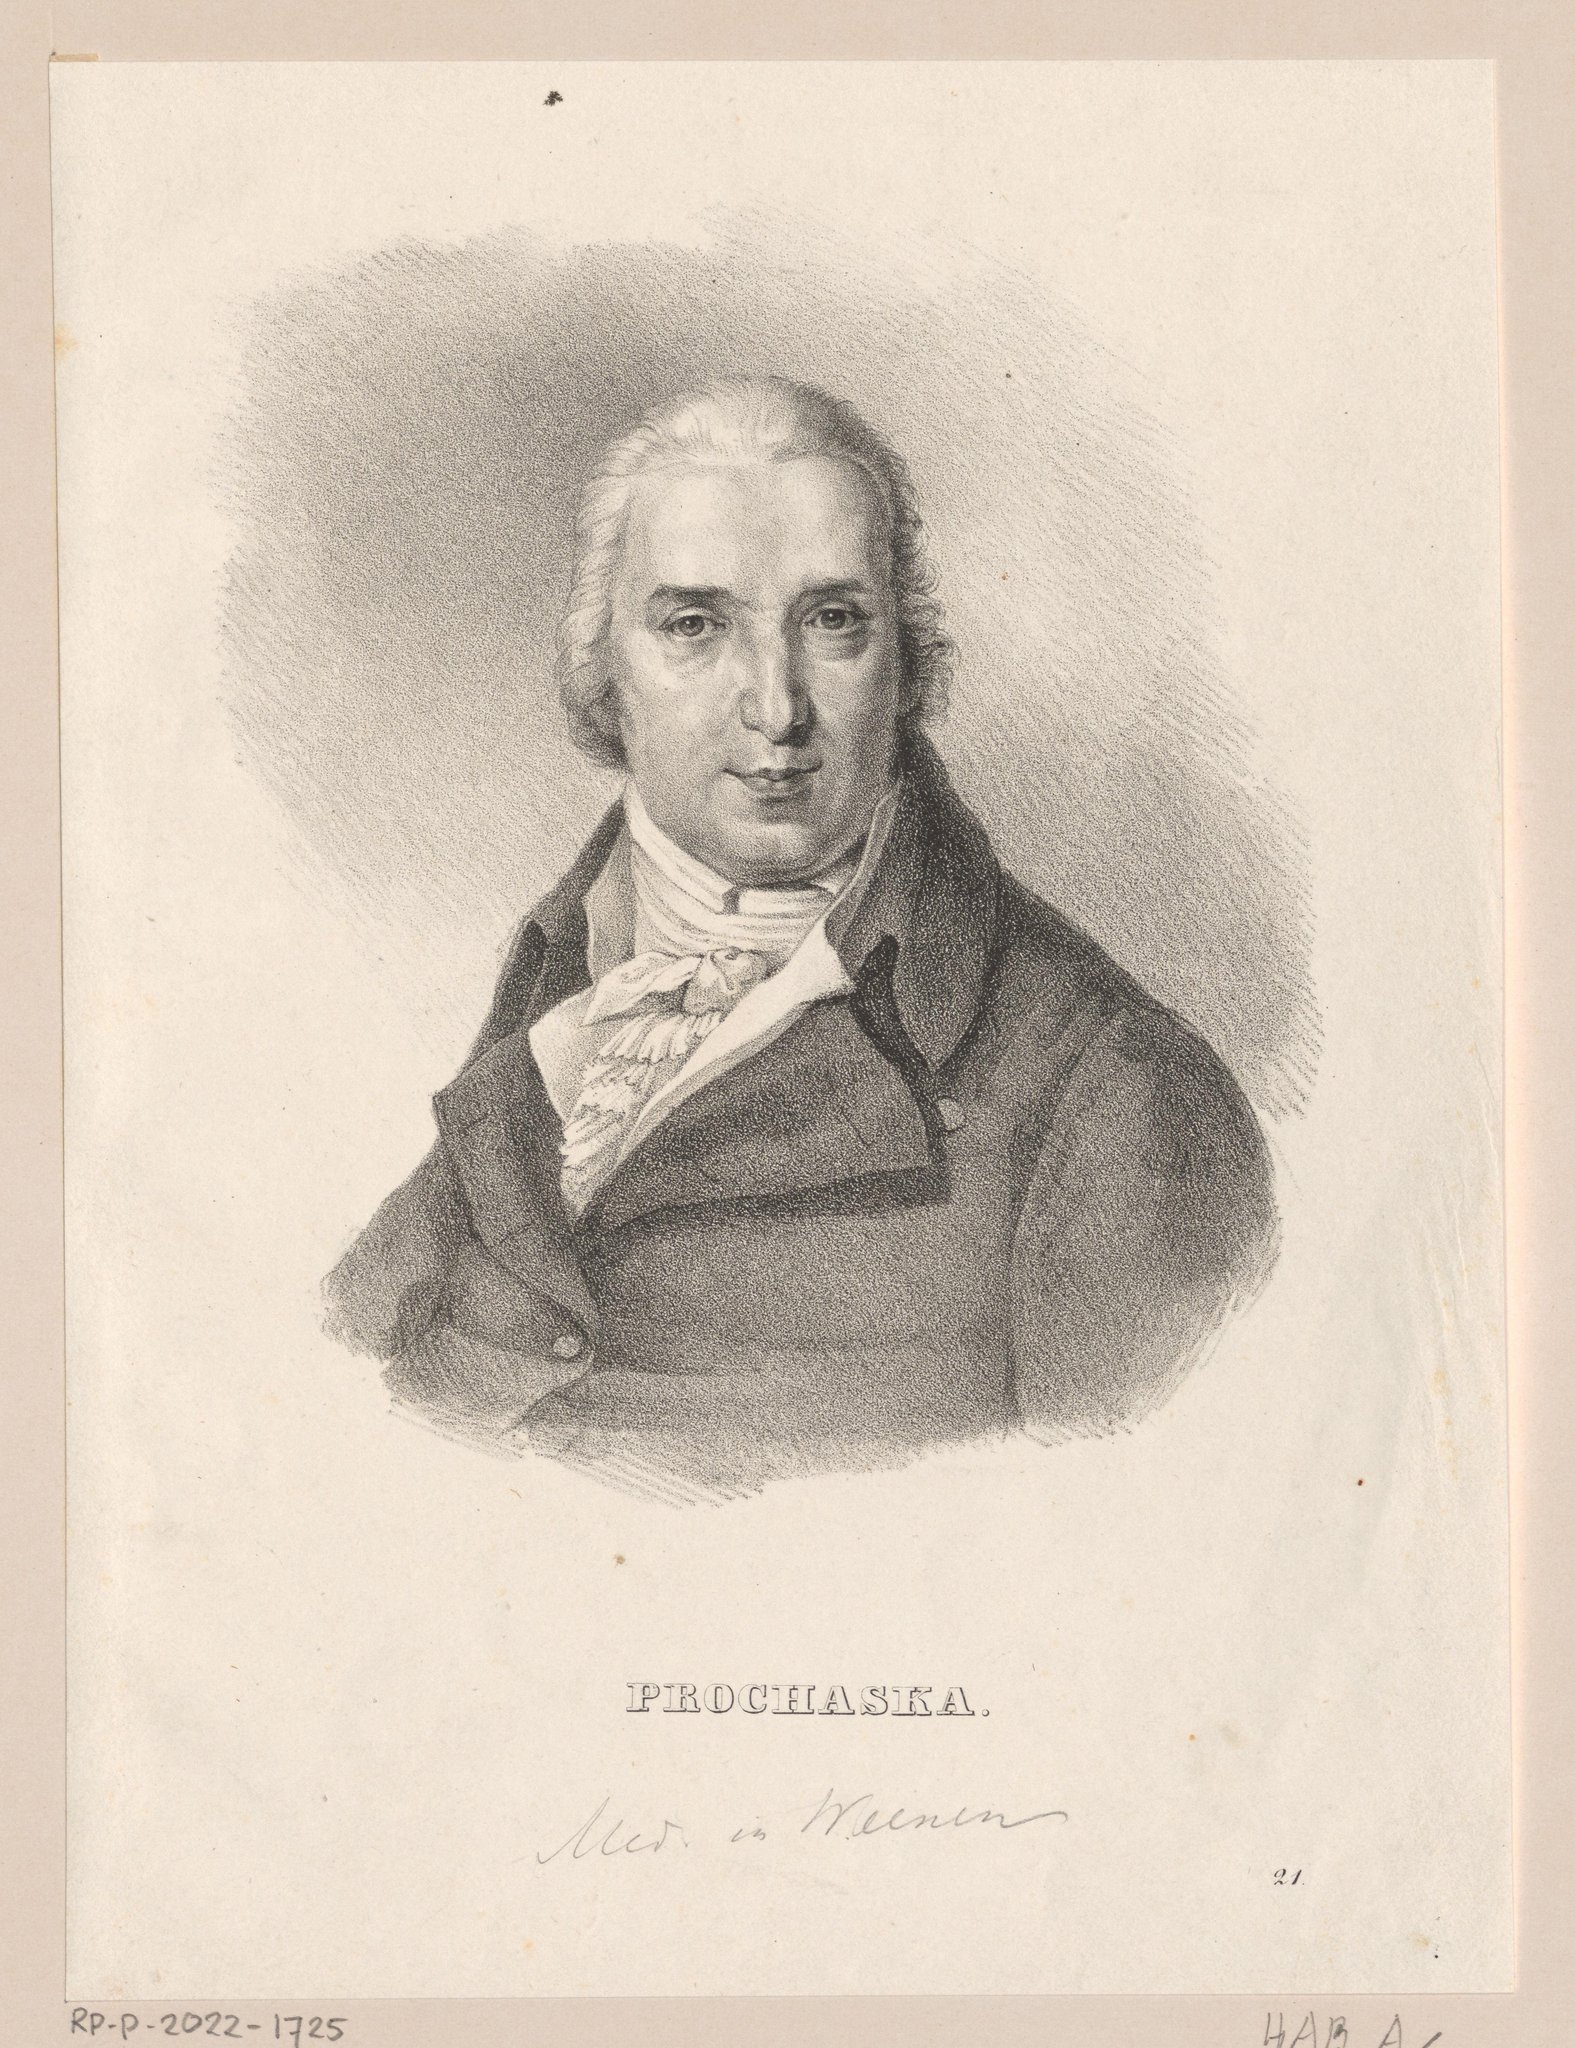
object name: print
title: Portret van Georg Prochaska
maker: Anonymous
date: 1789-1850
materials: paper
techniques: lithograph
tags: vienna, draughtsman, georg prochaska, historical persons, portrait of a writer, physician, doctor